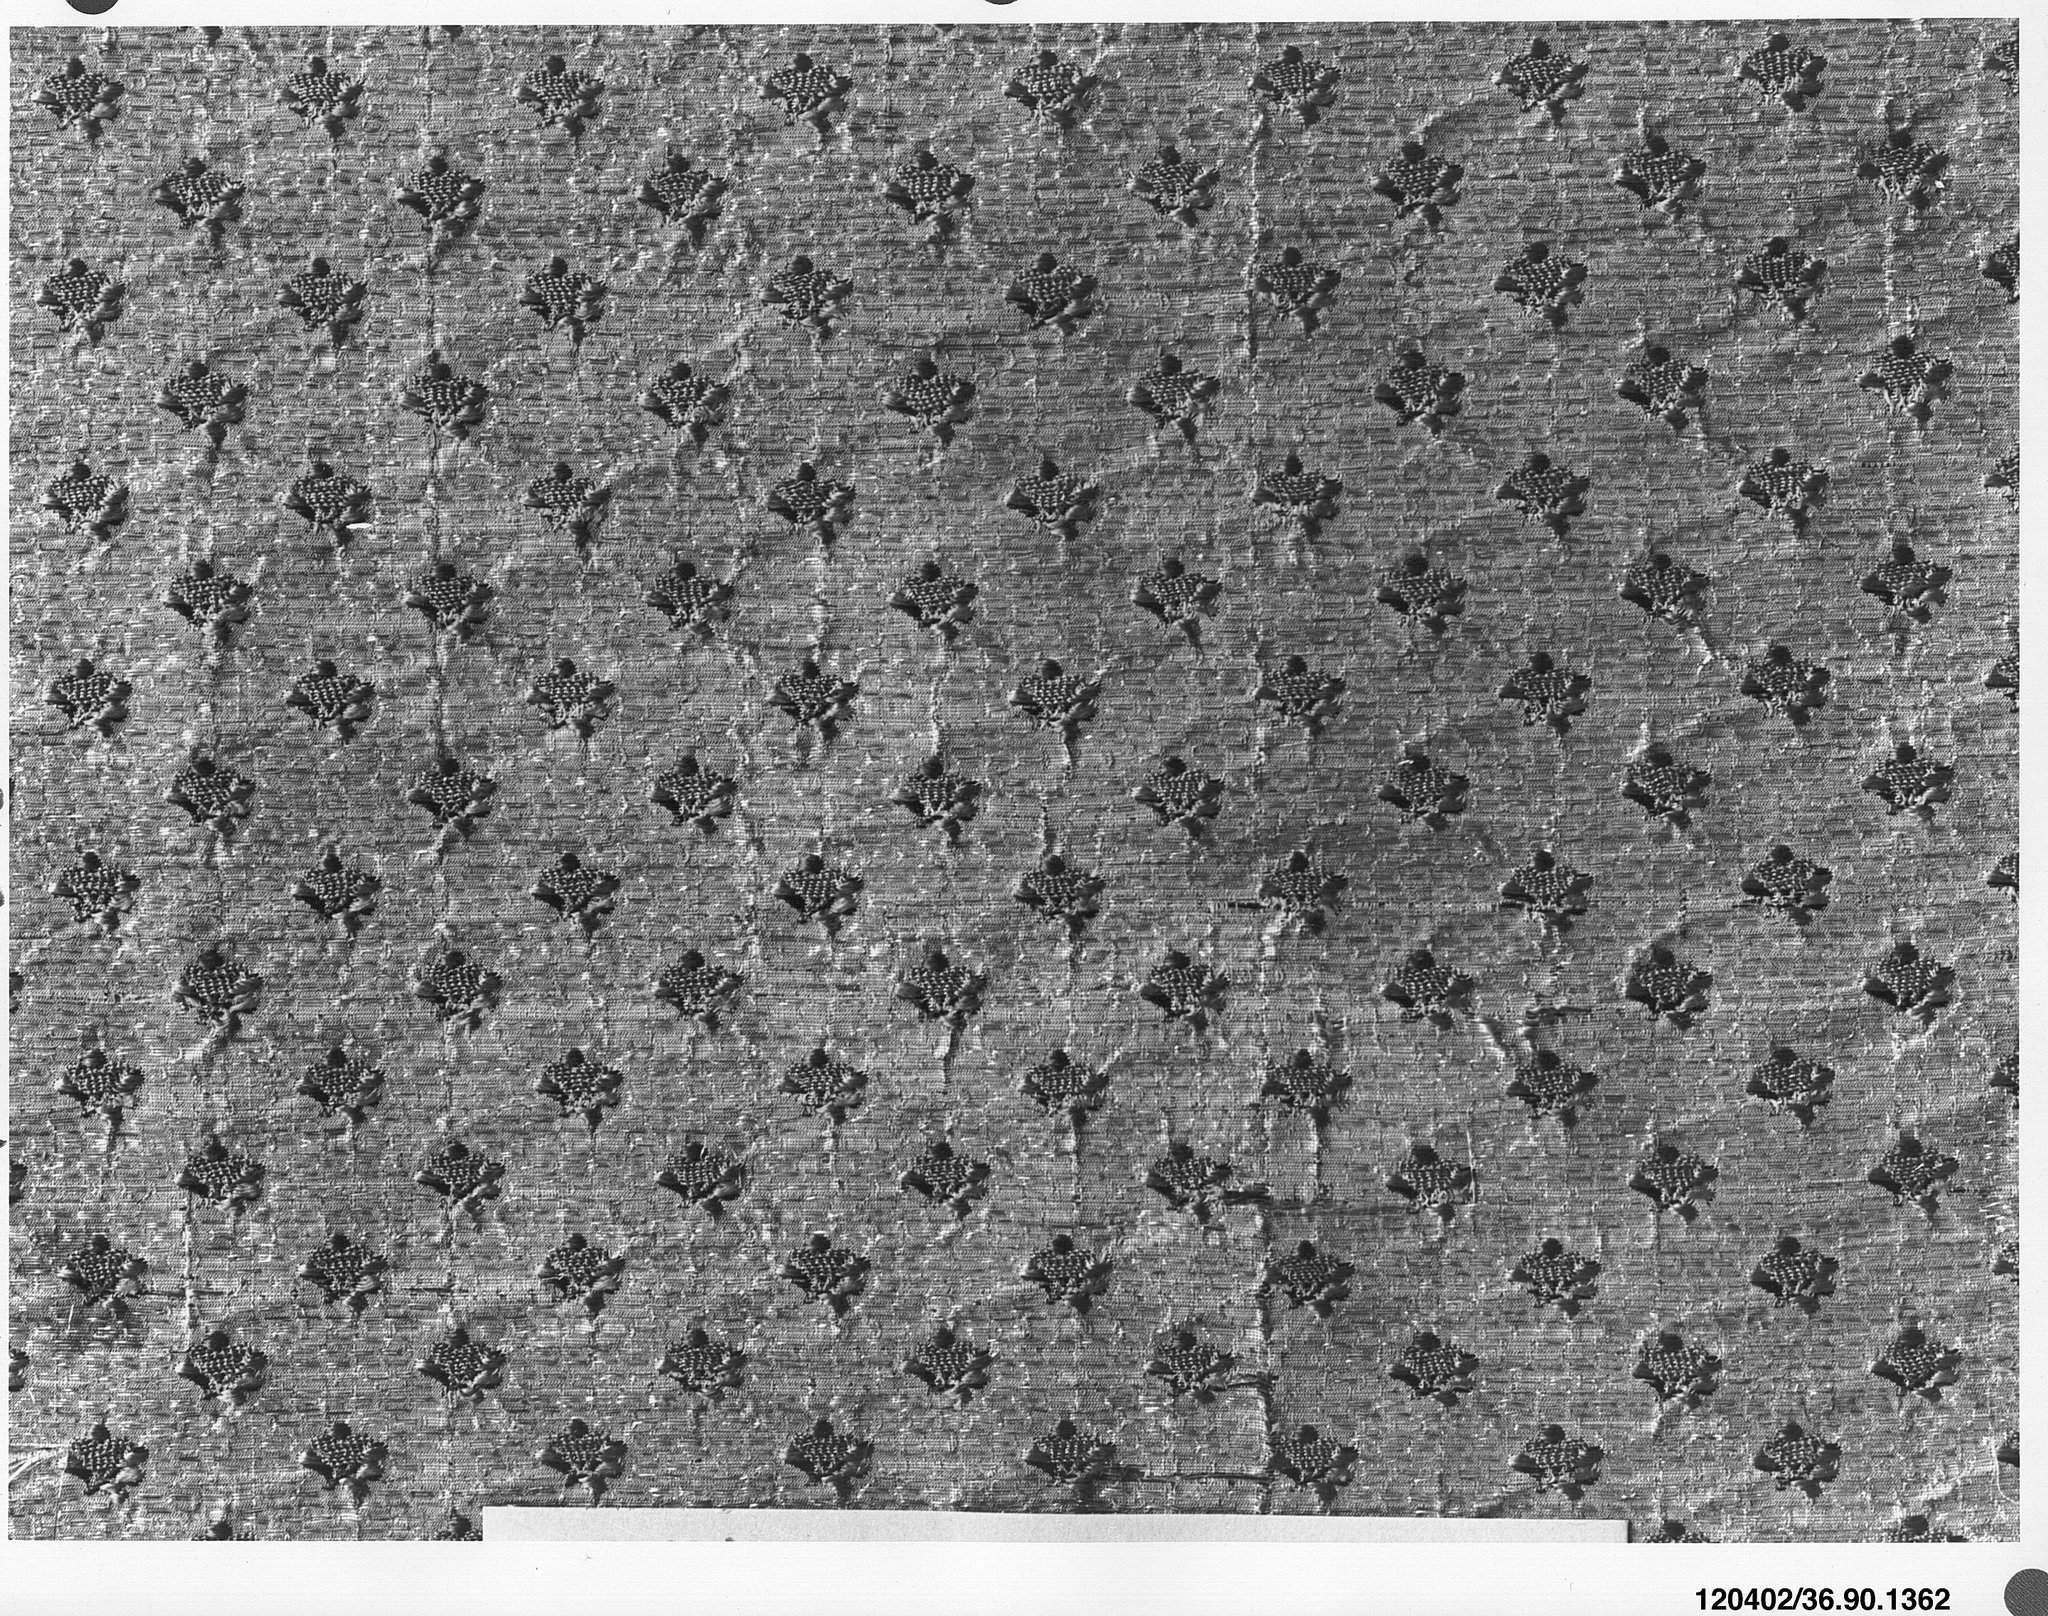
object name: piece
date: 1701-1800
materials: silk